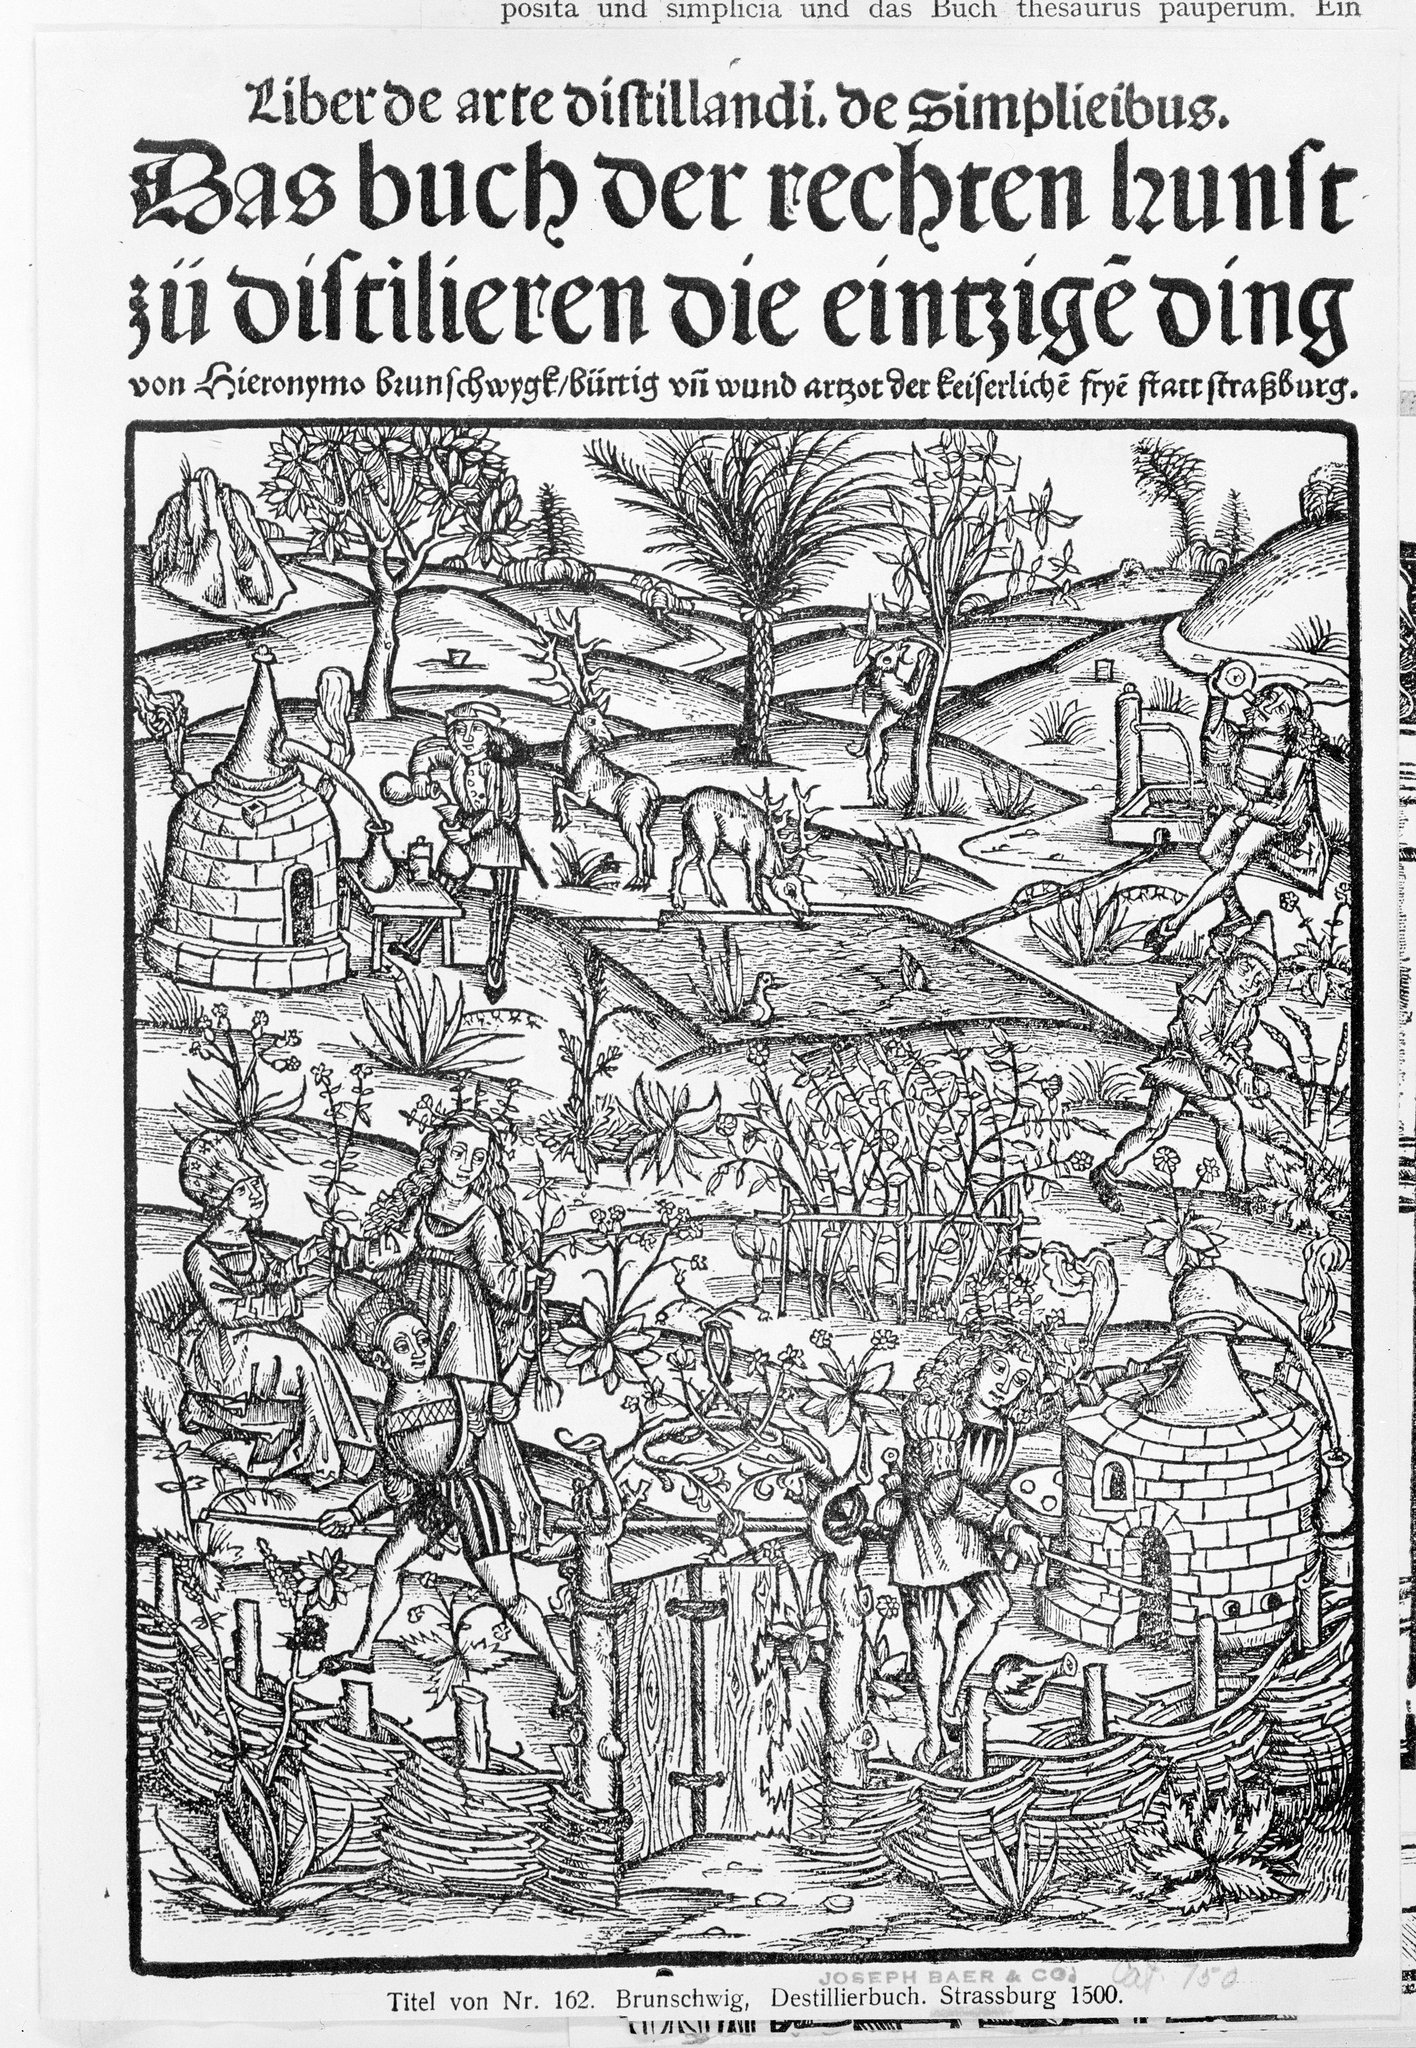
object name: book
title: Medicinarius. Das buch der Gesundheit. Liber de arte distillandi Simplicia et Composita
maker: johann grüninger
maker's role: printer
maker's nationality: german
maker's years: 1455-1533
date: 1505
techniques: woodcut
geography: germany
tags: men,women,deer,trees